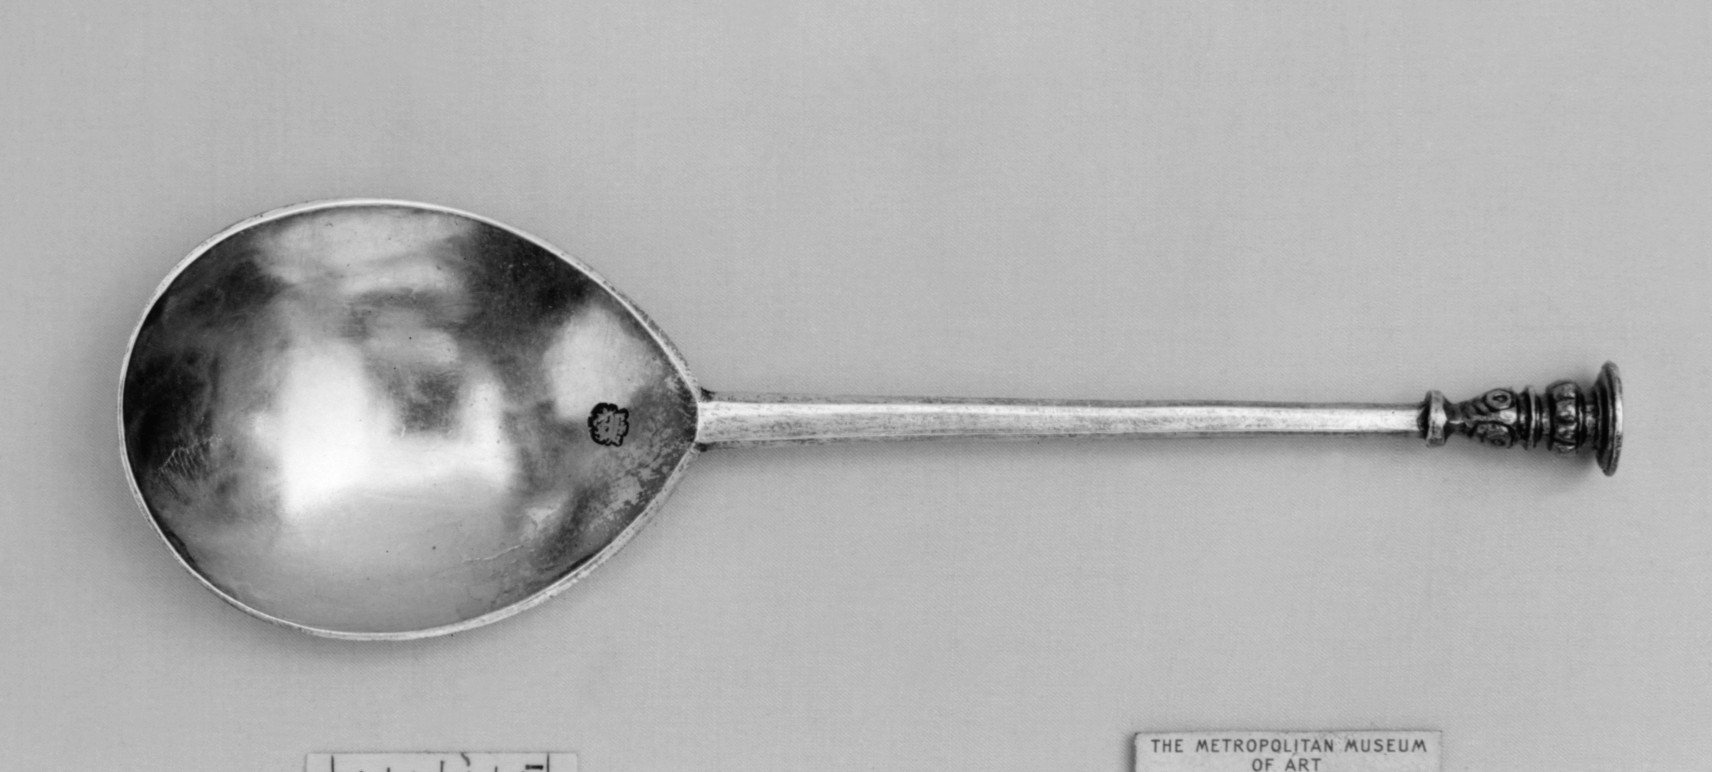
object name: spoon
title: Seal-top spoon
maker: daniel cary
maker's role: maker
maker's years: 1604-1640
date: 1633-1634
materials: gilt, silver